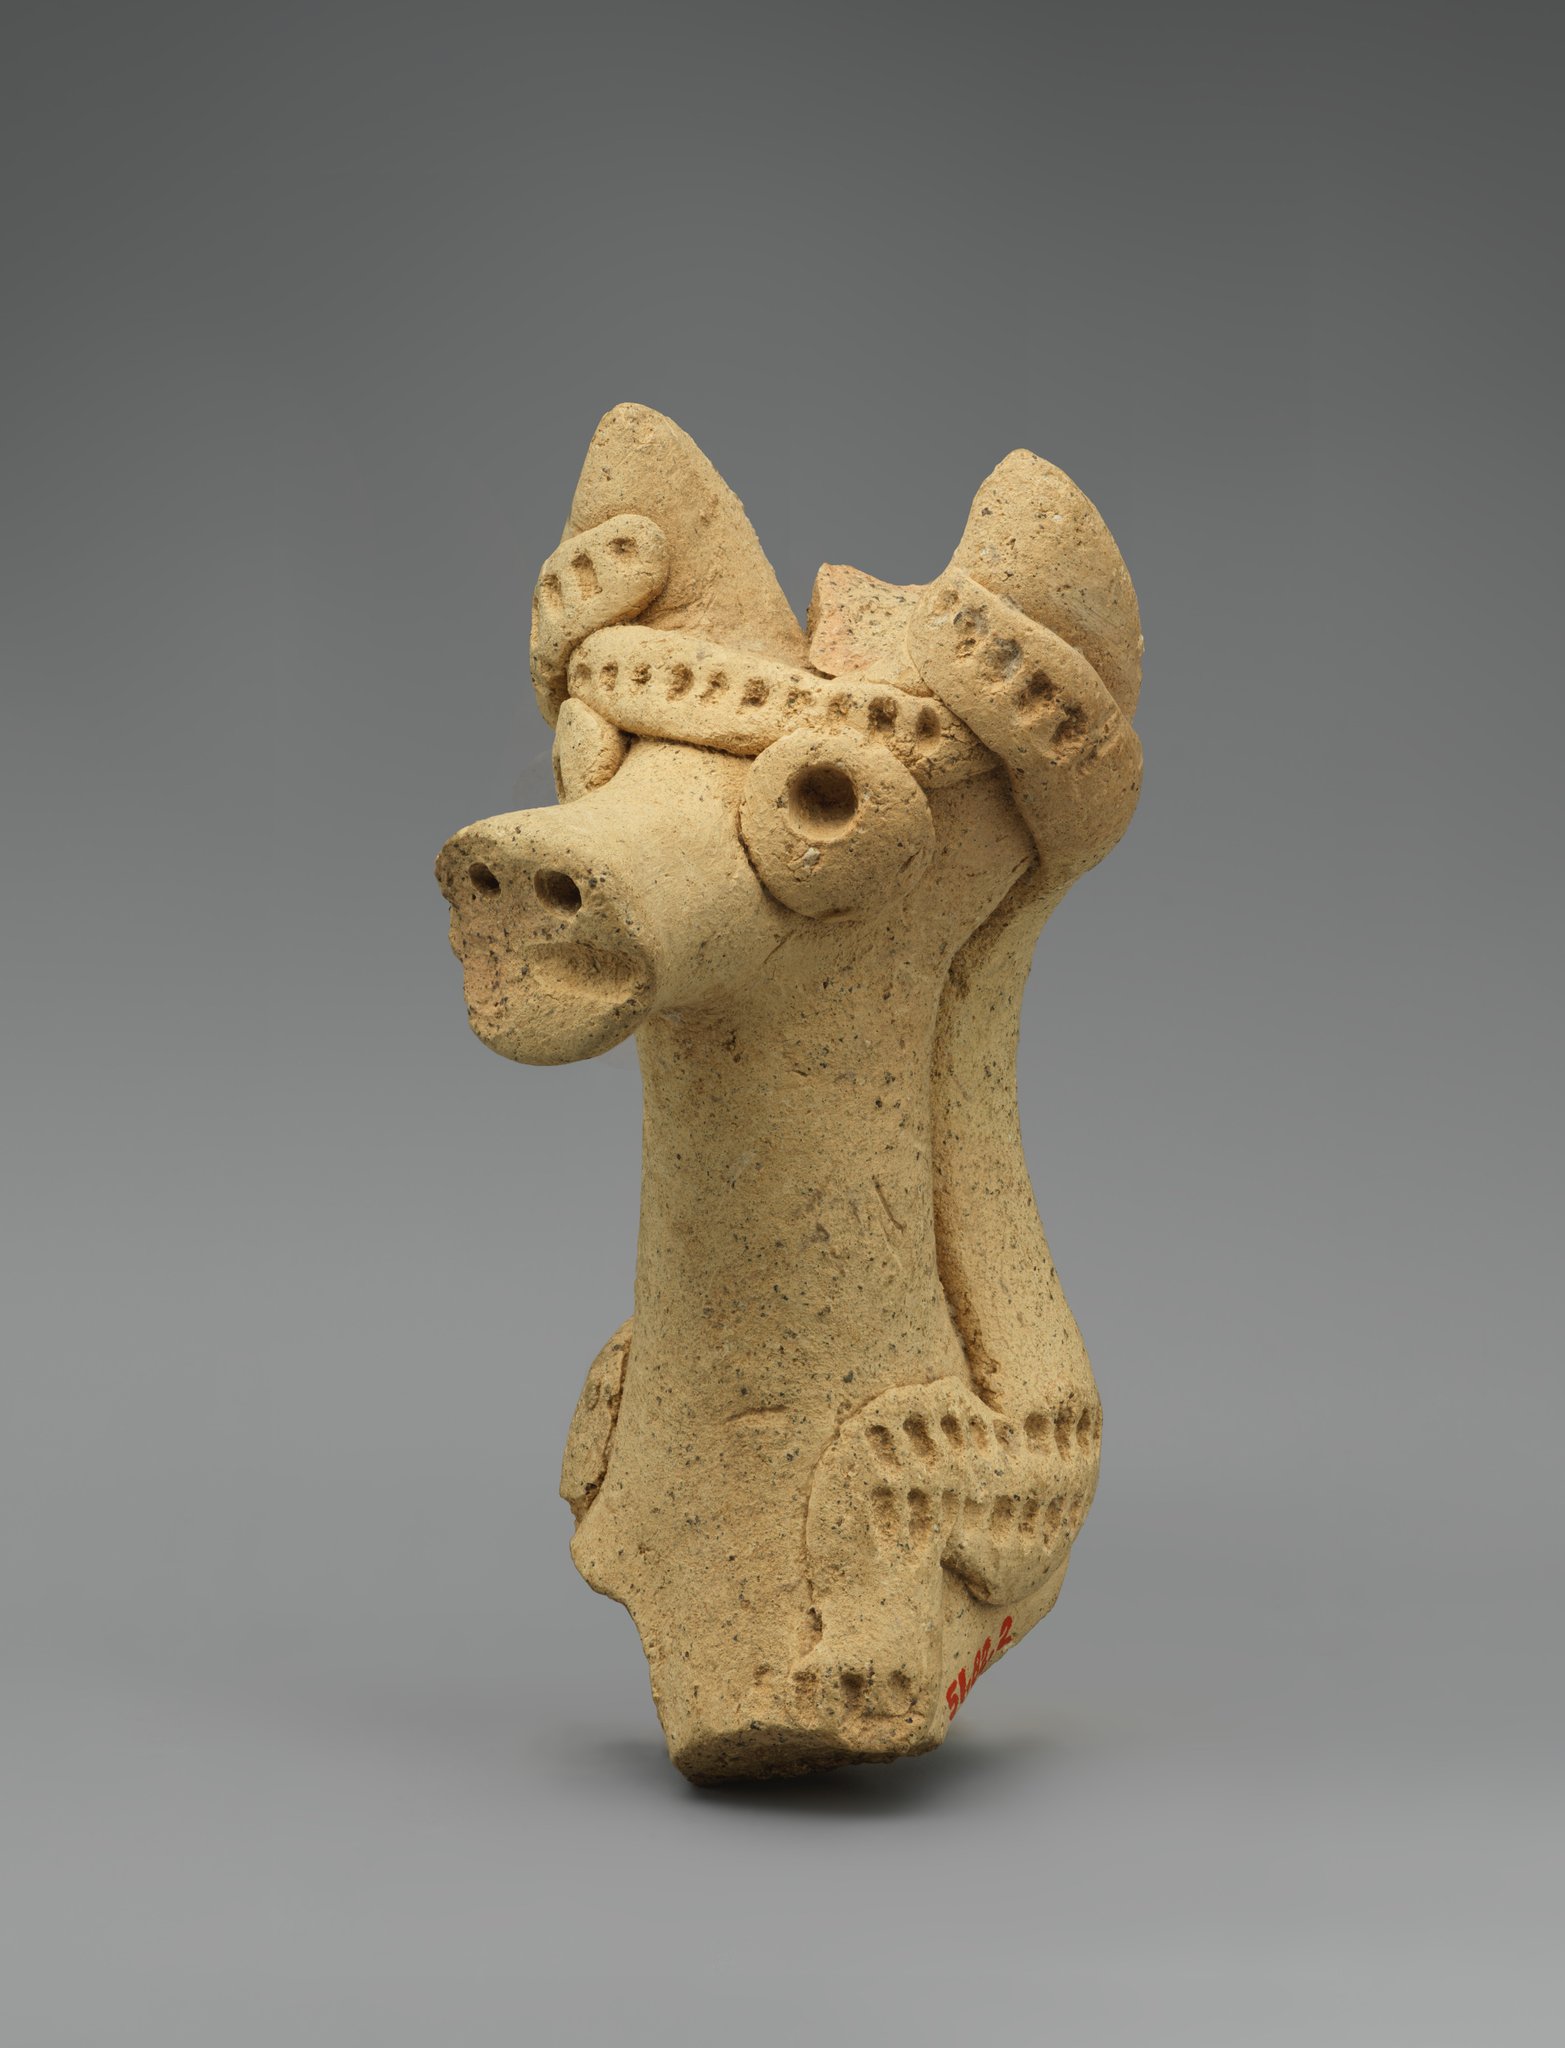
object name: sculpture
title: Figure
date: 1750 BCE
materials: ceramic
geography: syria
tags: animals